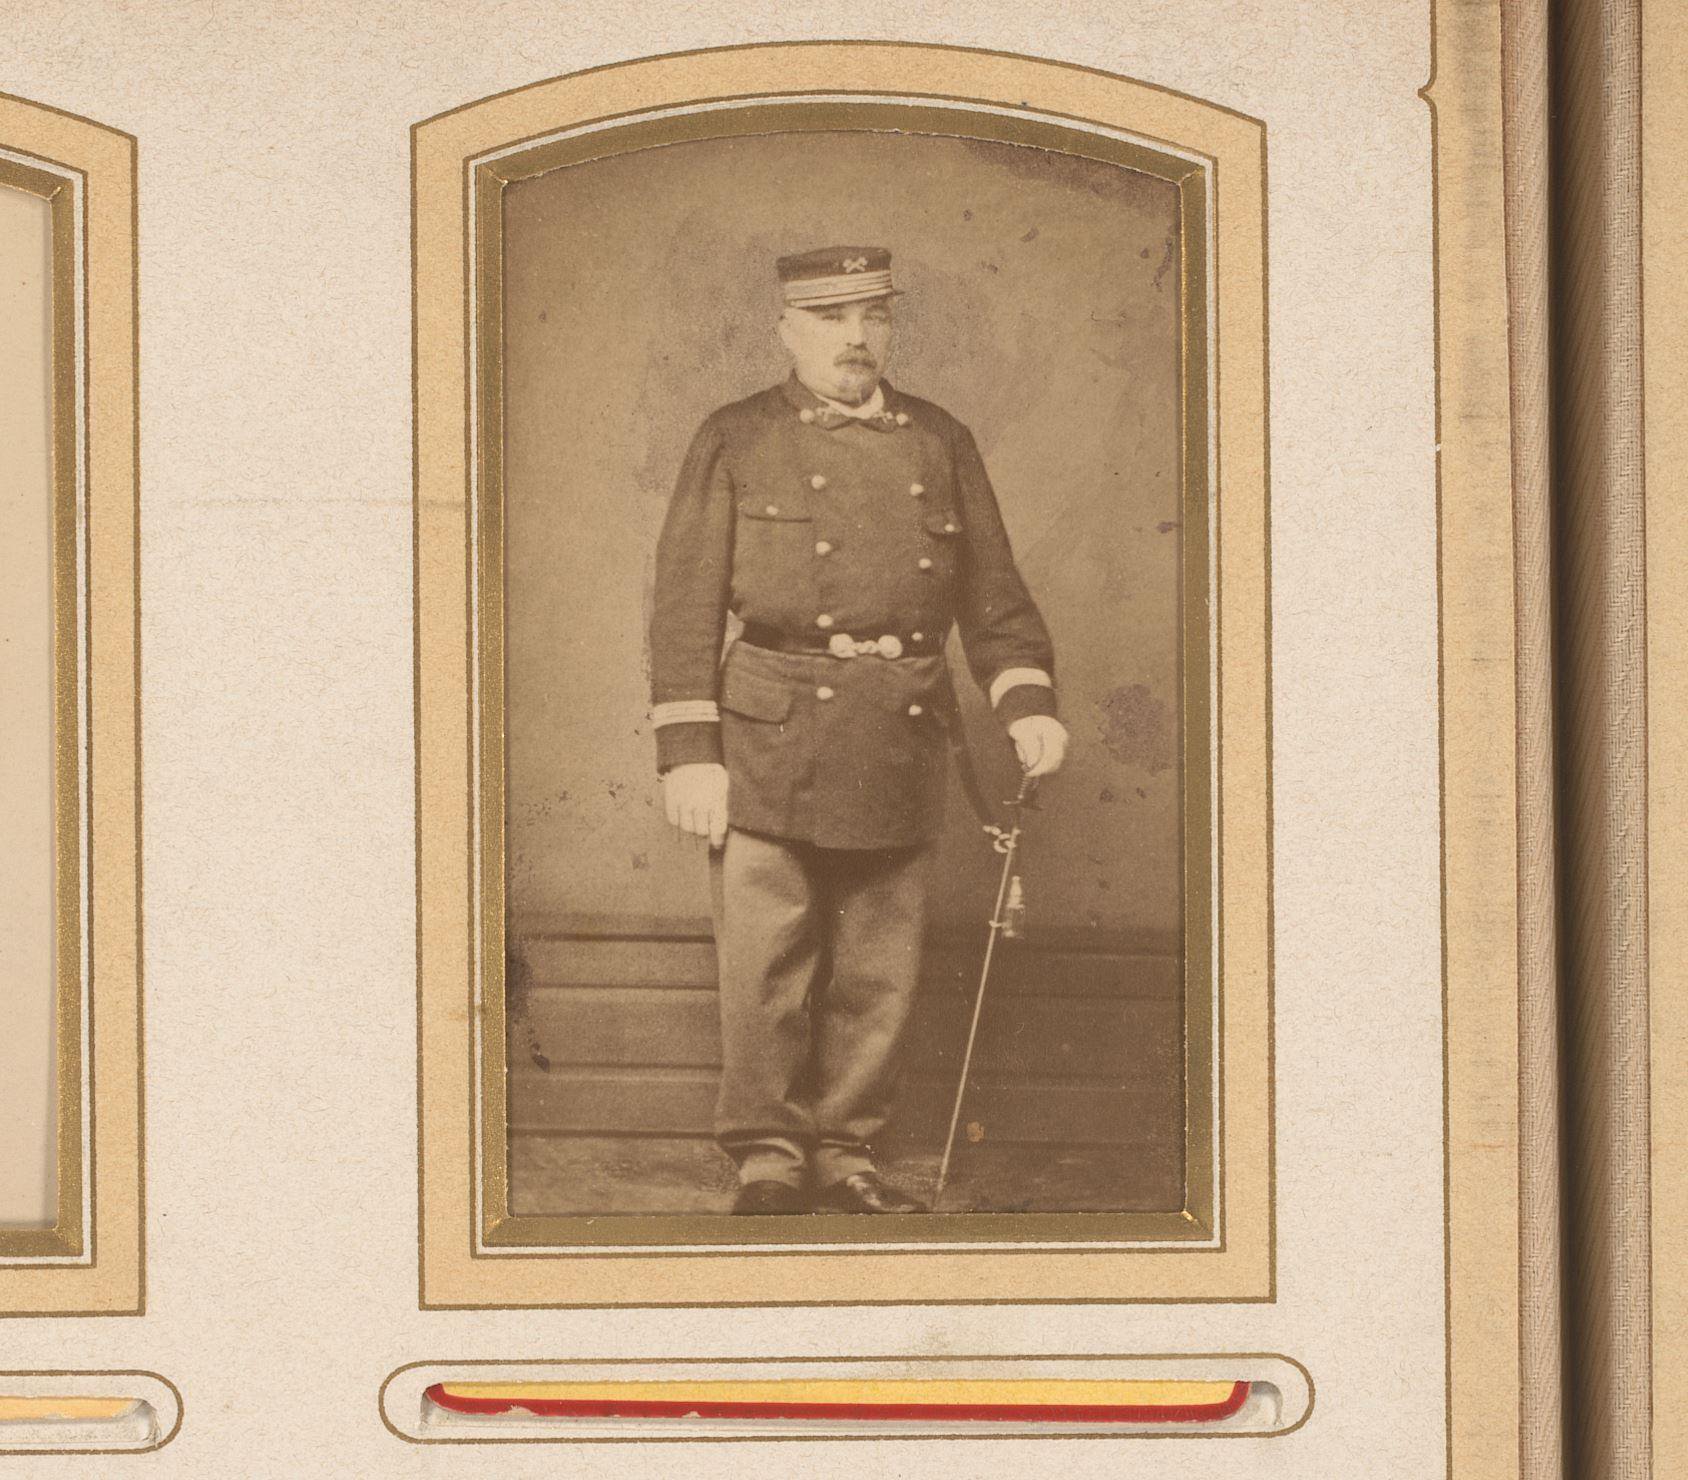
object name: album leaf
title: Portret van een man in een militair uniform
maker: schwindenhammer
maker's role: fotograaf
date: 1860-1900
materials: cardboard, photographic support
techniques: albumen print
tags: adult man, historical persons, (military) uniforms